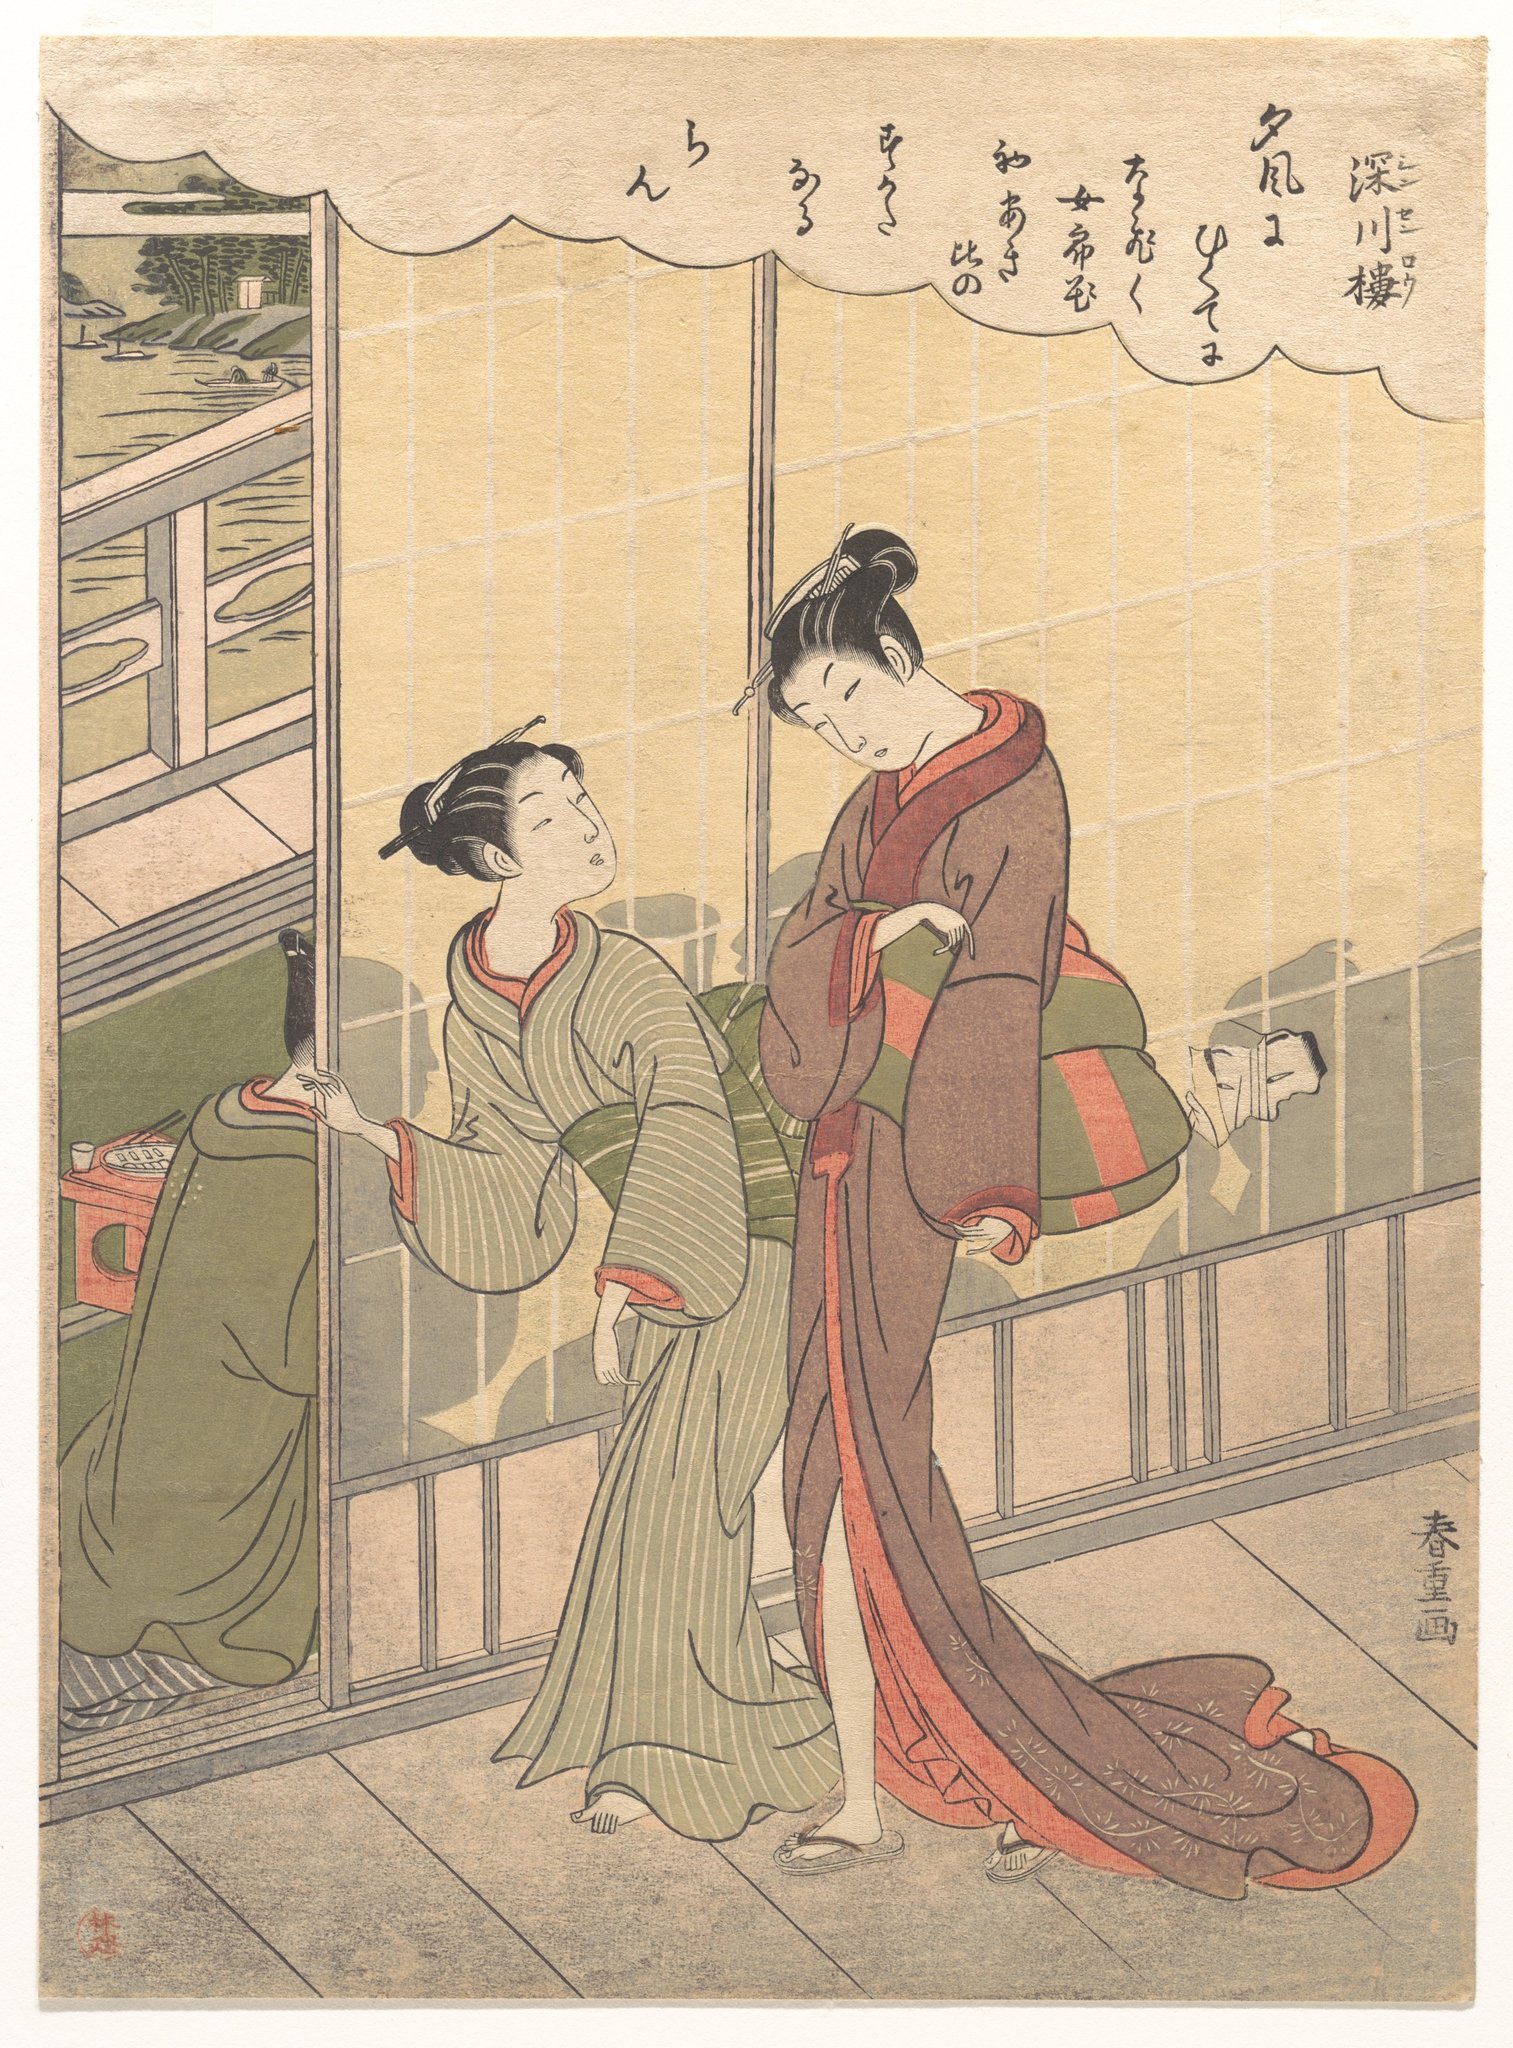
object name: print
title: Scene of the Pleasure Quarter at Fukagawa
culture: japanese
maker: suzuki harushige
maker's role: artist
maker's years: 1747-1818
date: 1767-1800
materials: ink, paper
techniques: woodblock print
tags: women